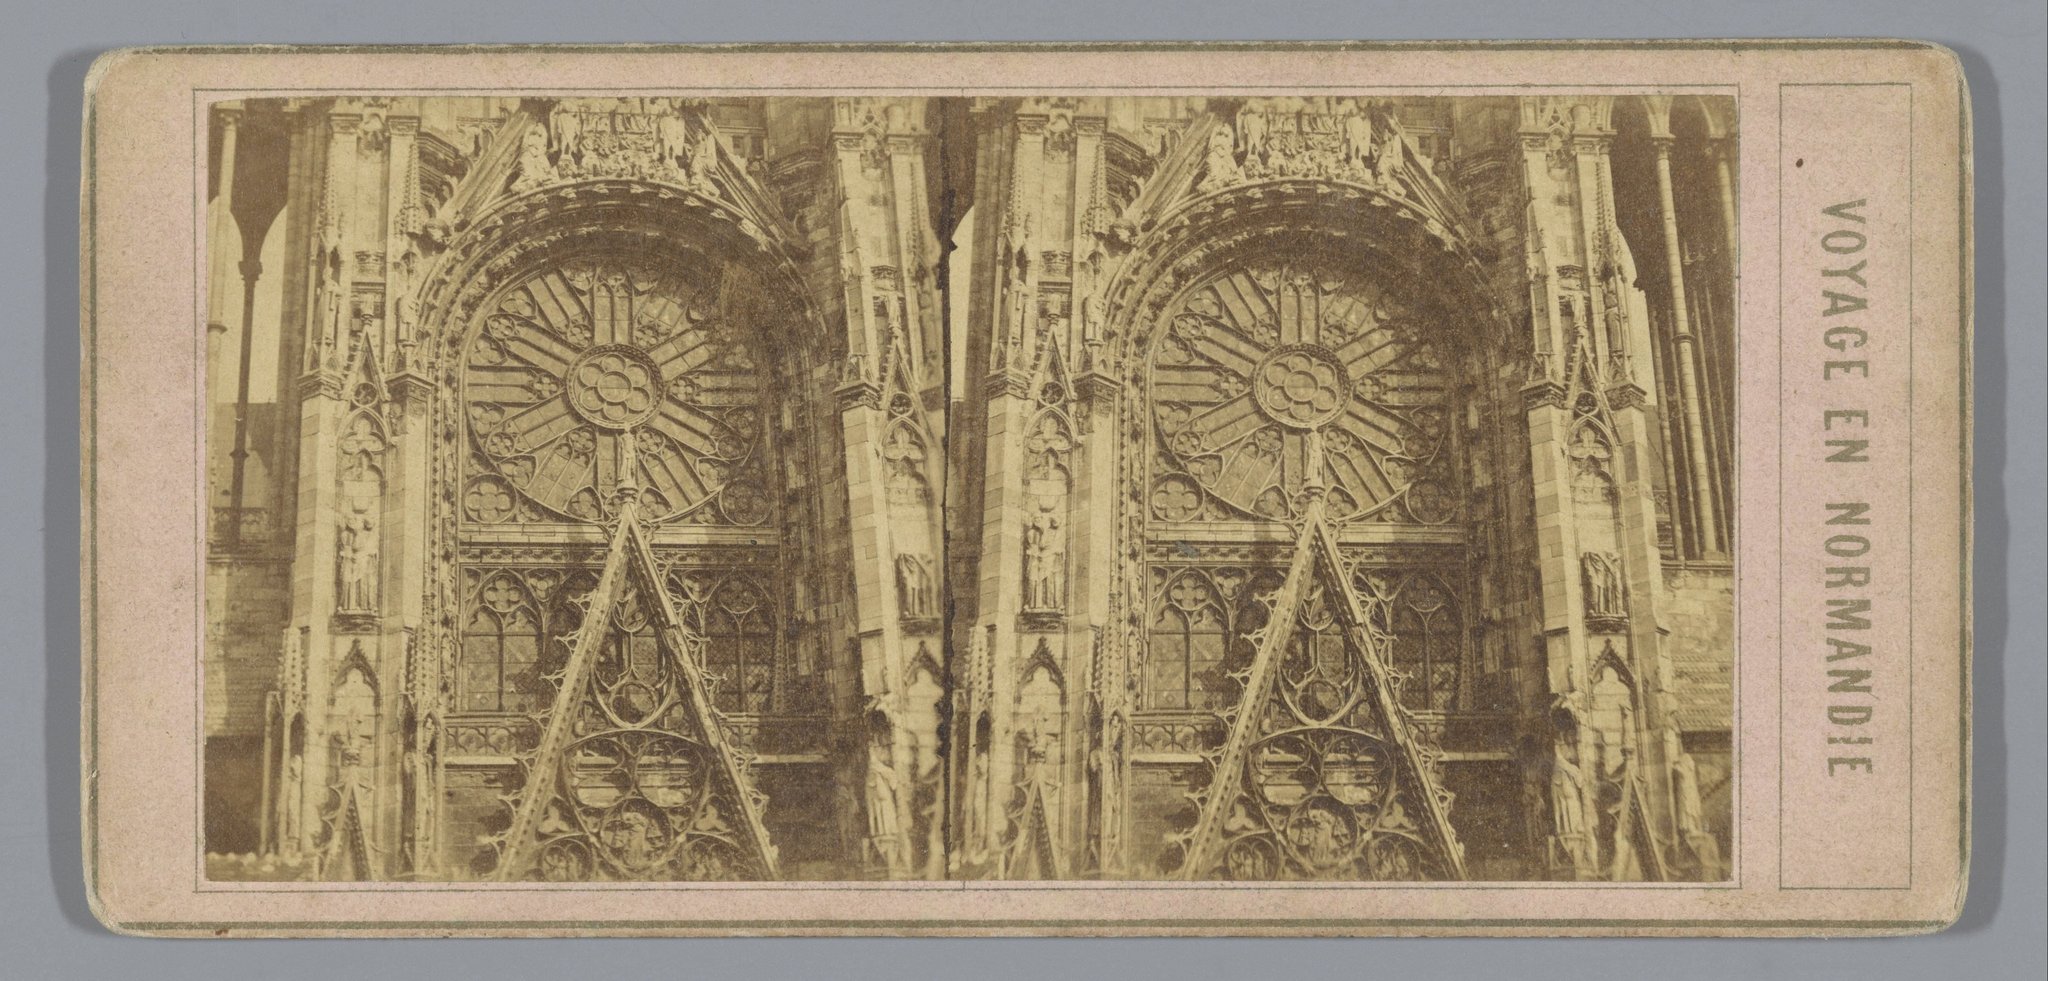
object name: stereograph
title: Voyage en Normandie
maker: Anonymous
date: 1850-1880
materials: cardboard, photographic support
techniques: albumen print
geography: rouen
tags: church-window, e.g. rose-window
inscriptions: inscription: ‘Men ziet mooie [...]’